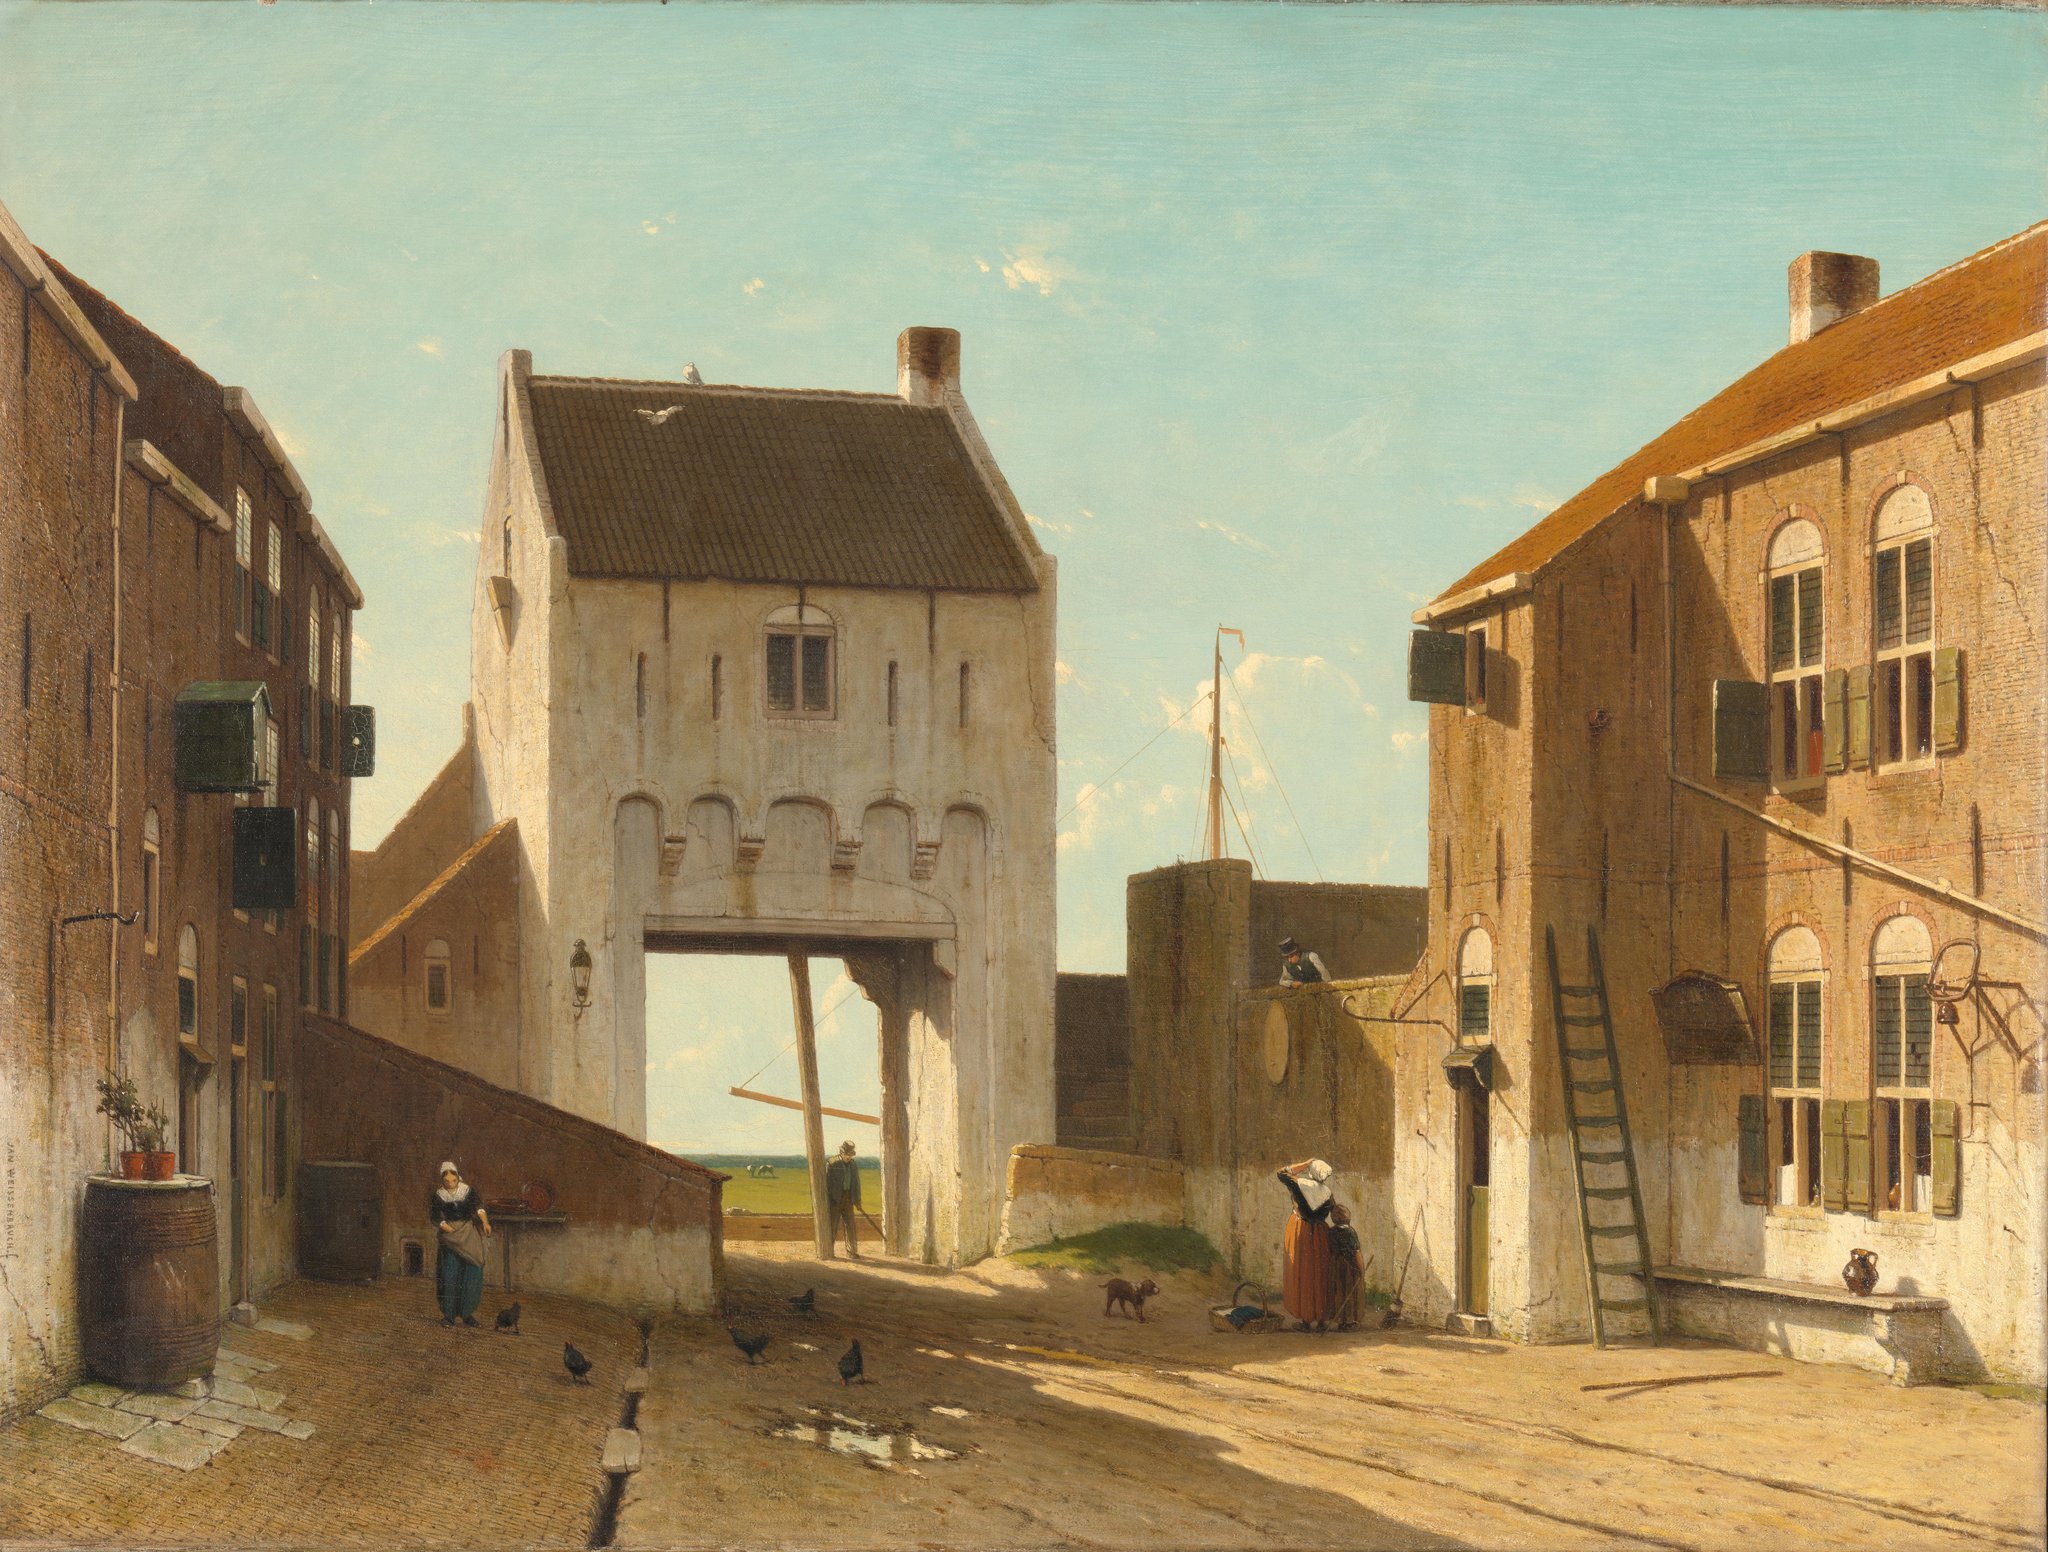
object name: painting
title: A Town Gate in Leerdam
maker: jan weissenbruch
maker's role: painter, print maker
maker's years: 1822-1880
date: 1868-1870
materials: canvas, oil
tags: city-gate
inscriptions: signature: ‘Jan Weissenbruch f’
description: Weissenbruch was partial to small Dutch towns where the 17th century was still palpable. The degree of detail in this townscape suggests that he painted it from life. However, because the exterior of the gate was more interesting, he simply turned it around. Moreover, the moment he portrayed was not chosen randomly. The sun shines brightly again after a rain shower, bathing everything in a crisp light.